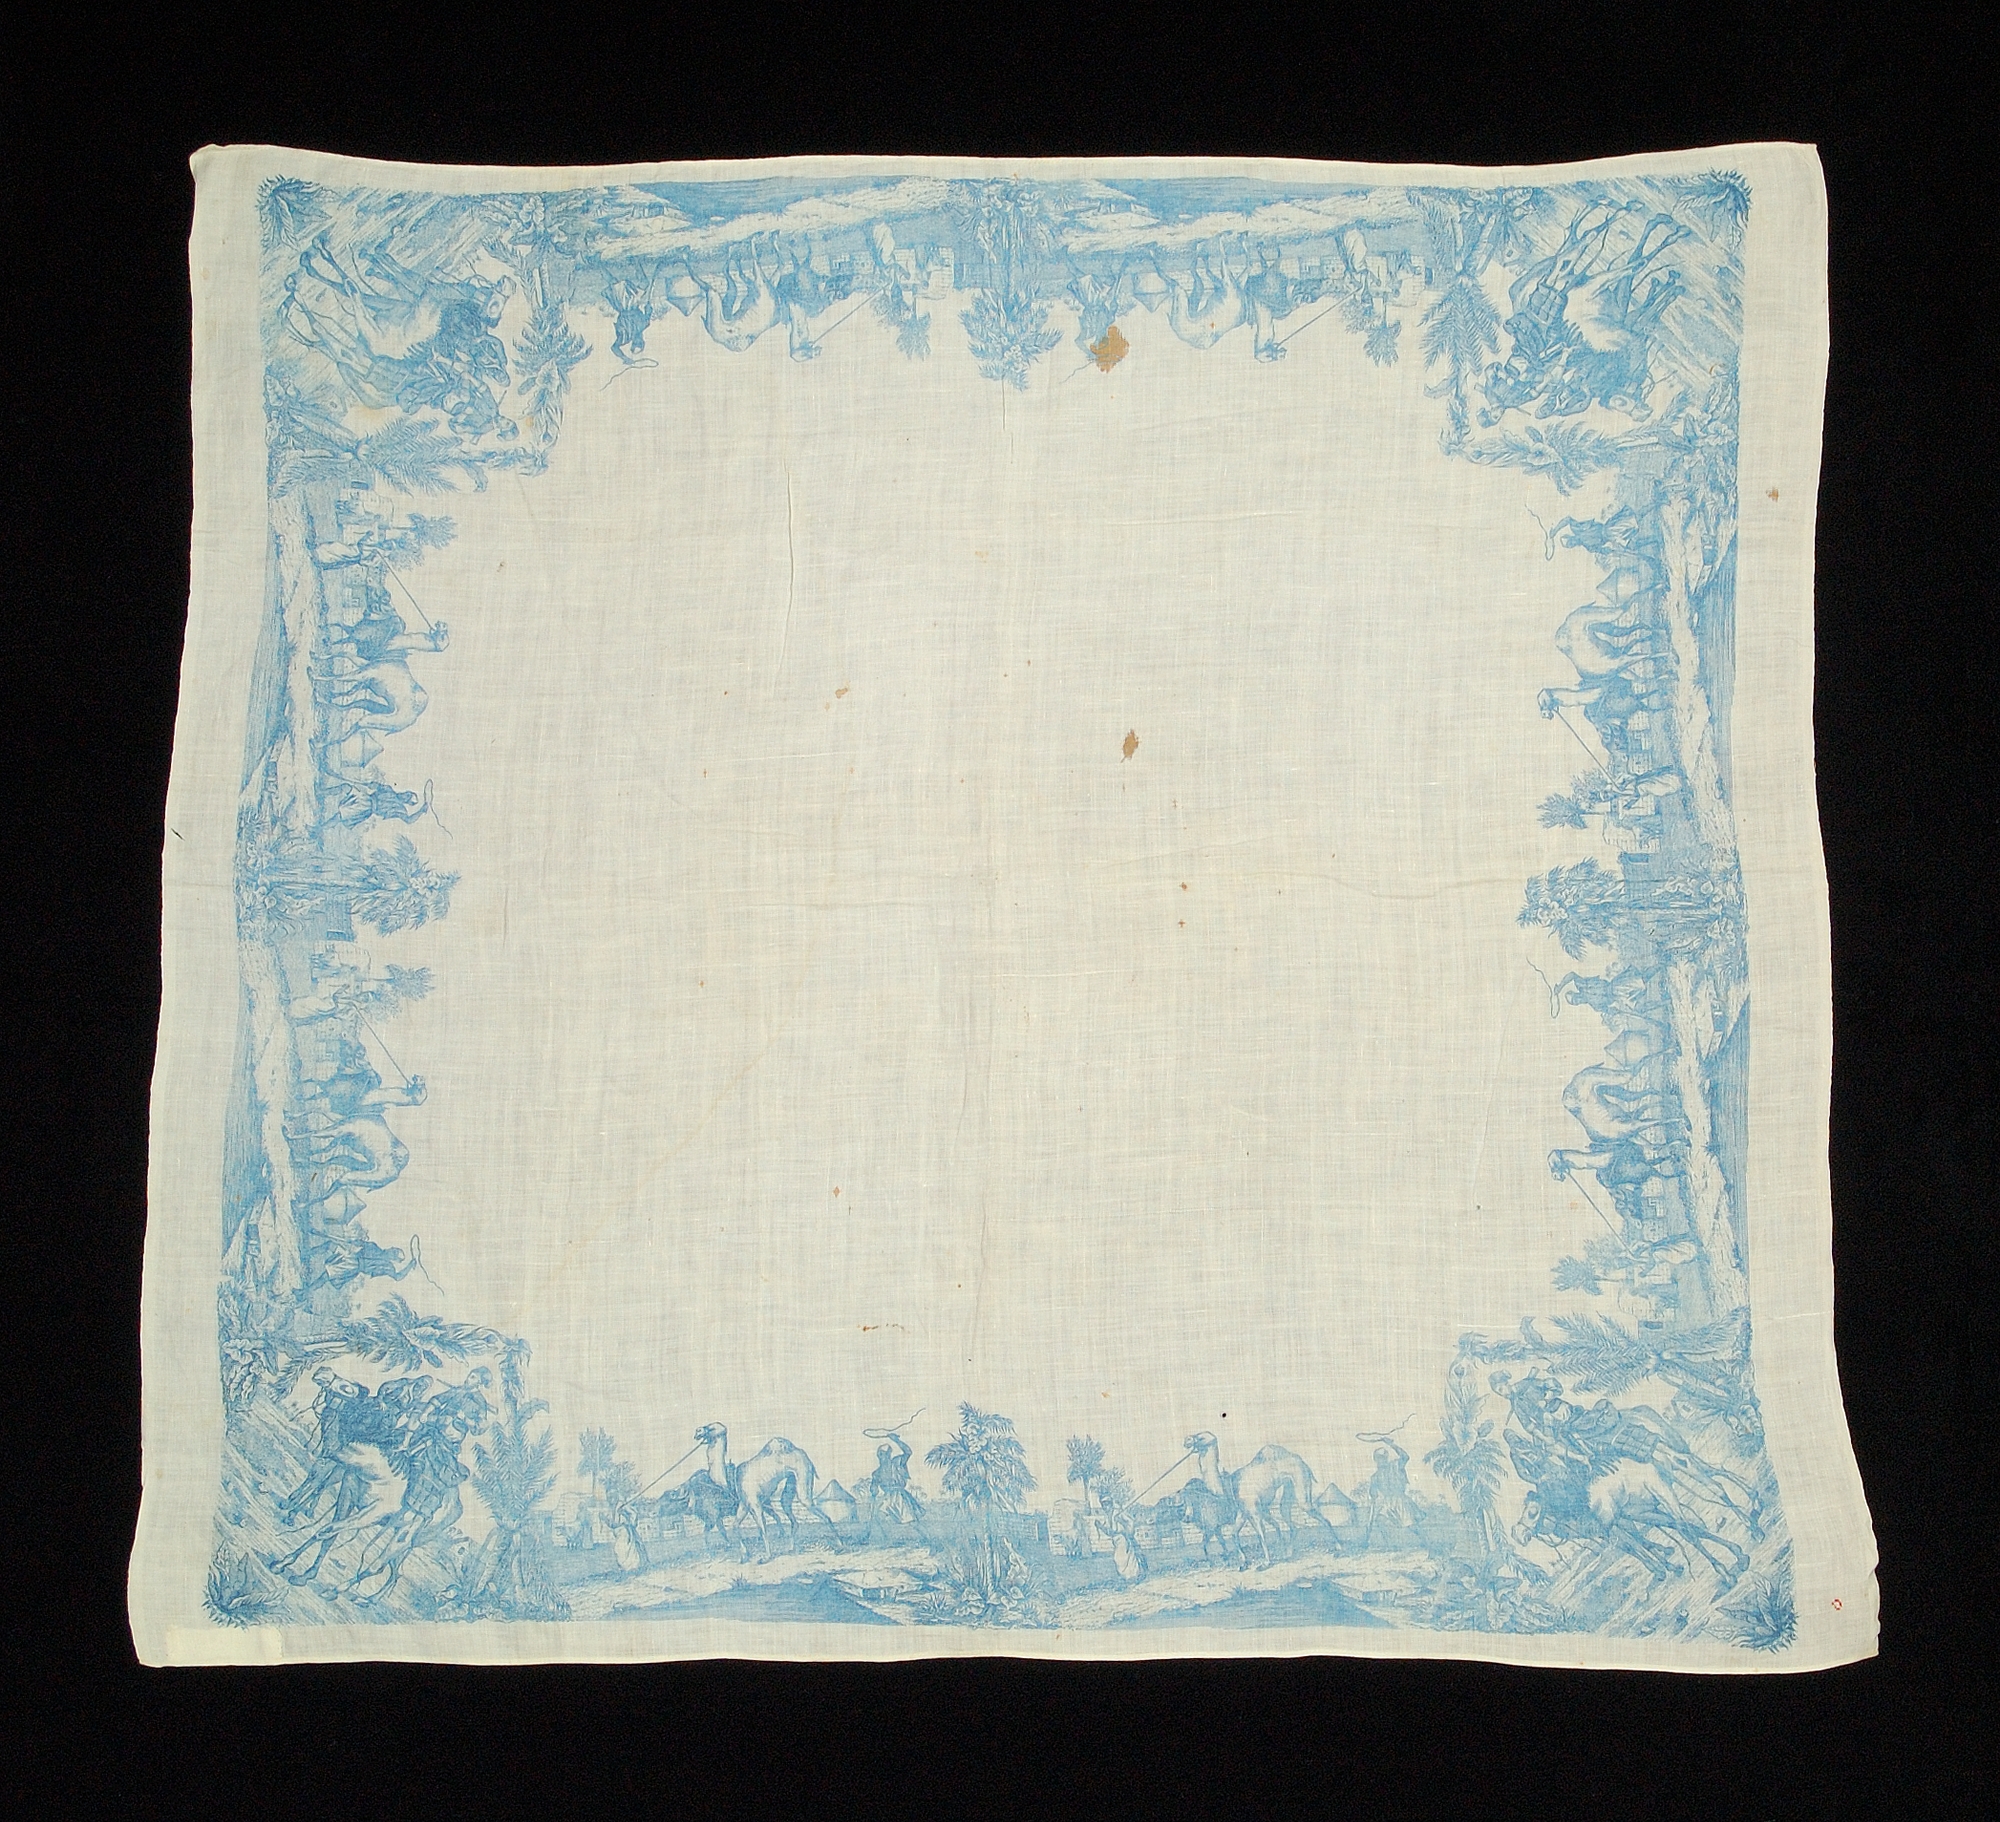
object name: handkerchief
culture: french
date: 1800-1810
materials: linen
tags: men,camels